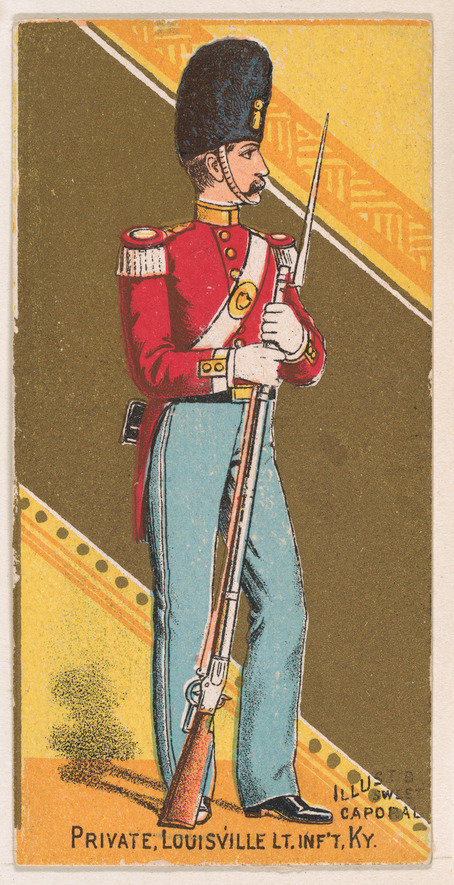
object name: print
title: Private, Louisville, Light Infantry, Kentucky, from the Military Series (N224) issued by Kinney Tobacco Company to promote Sweet Caporal Cigarettes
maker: kinney brothers tobacco company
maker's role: publisher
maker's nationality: american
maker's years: 1869-2011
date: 1888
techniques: color lithograph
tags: military,firearms,men,profiles